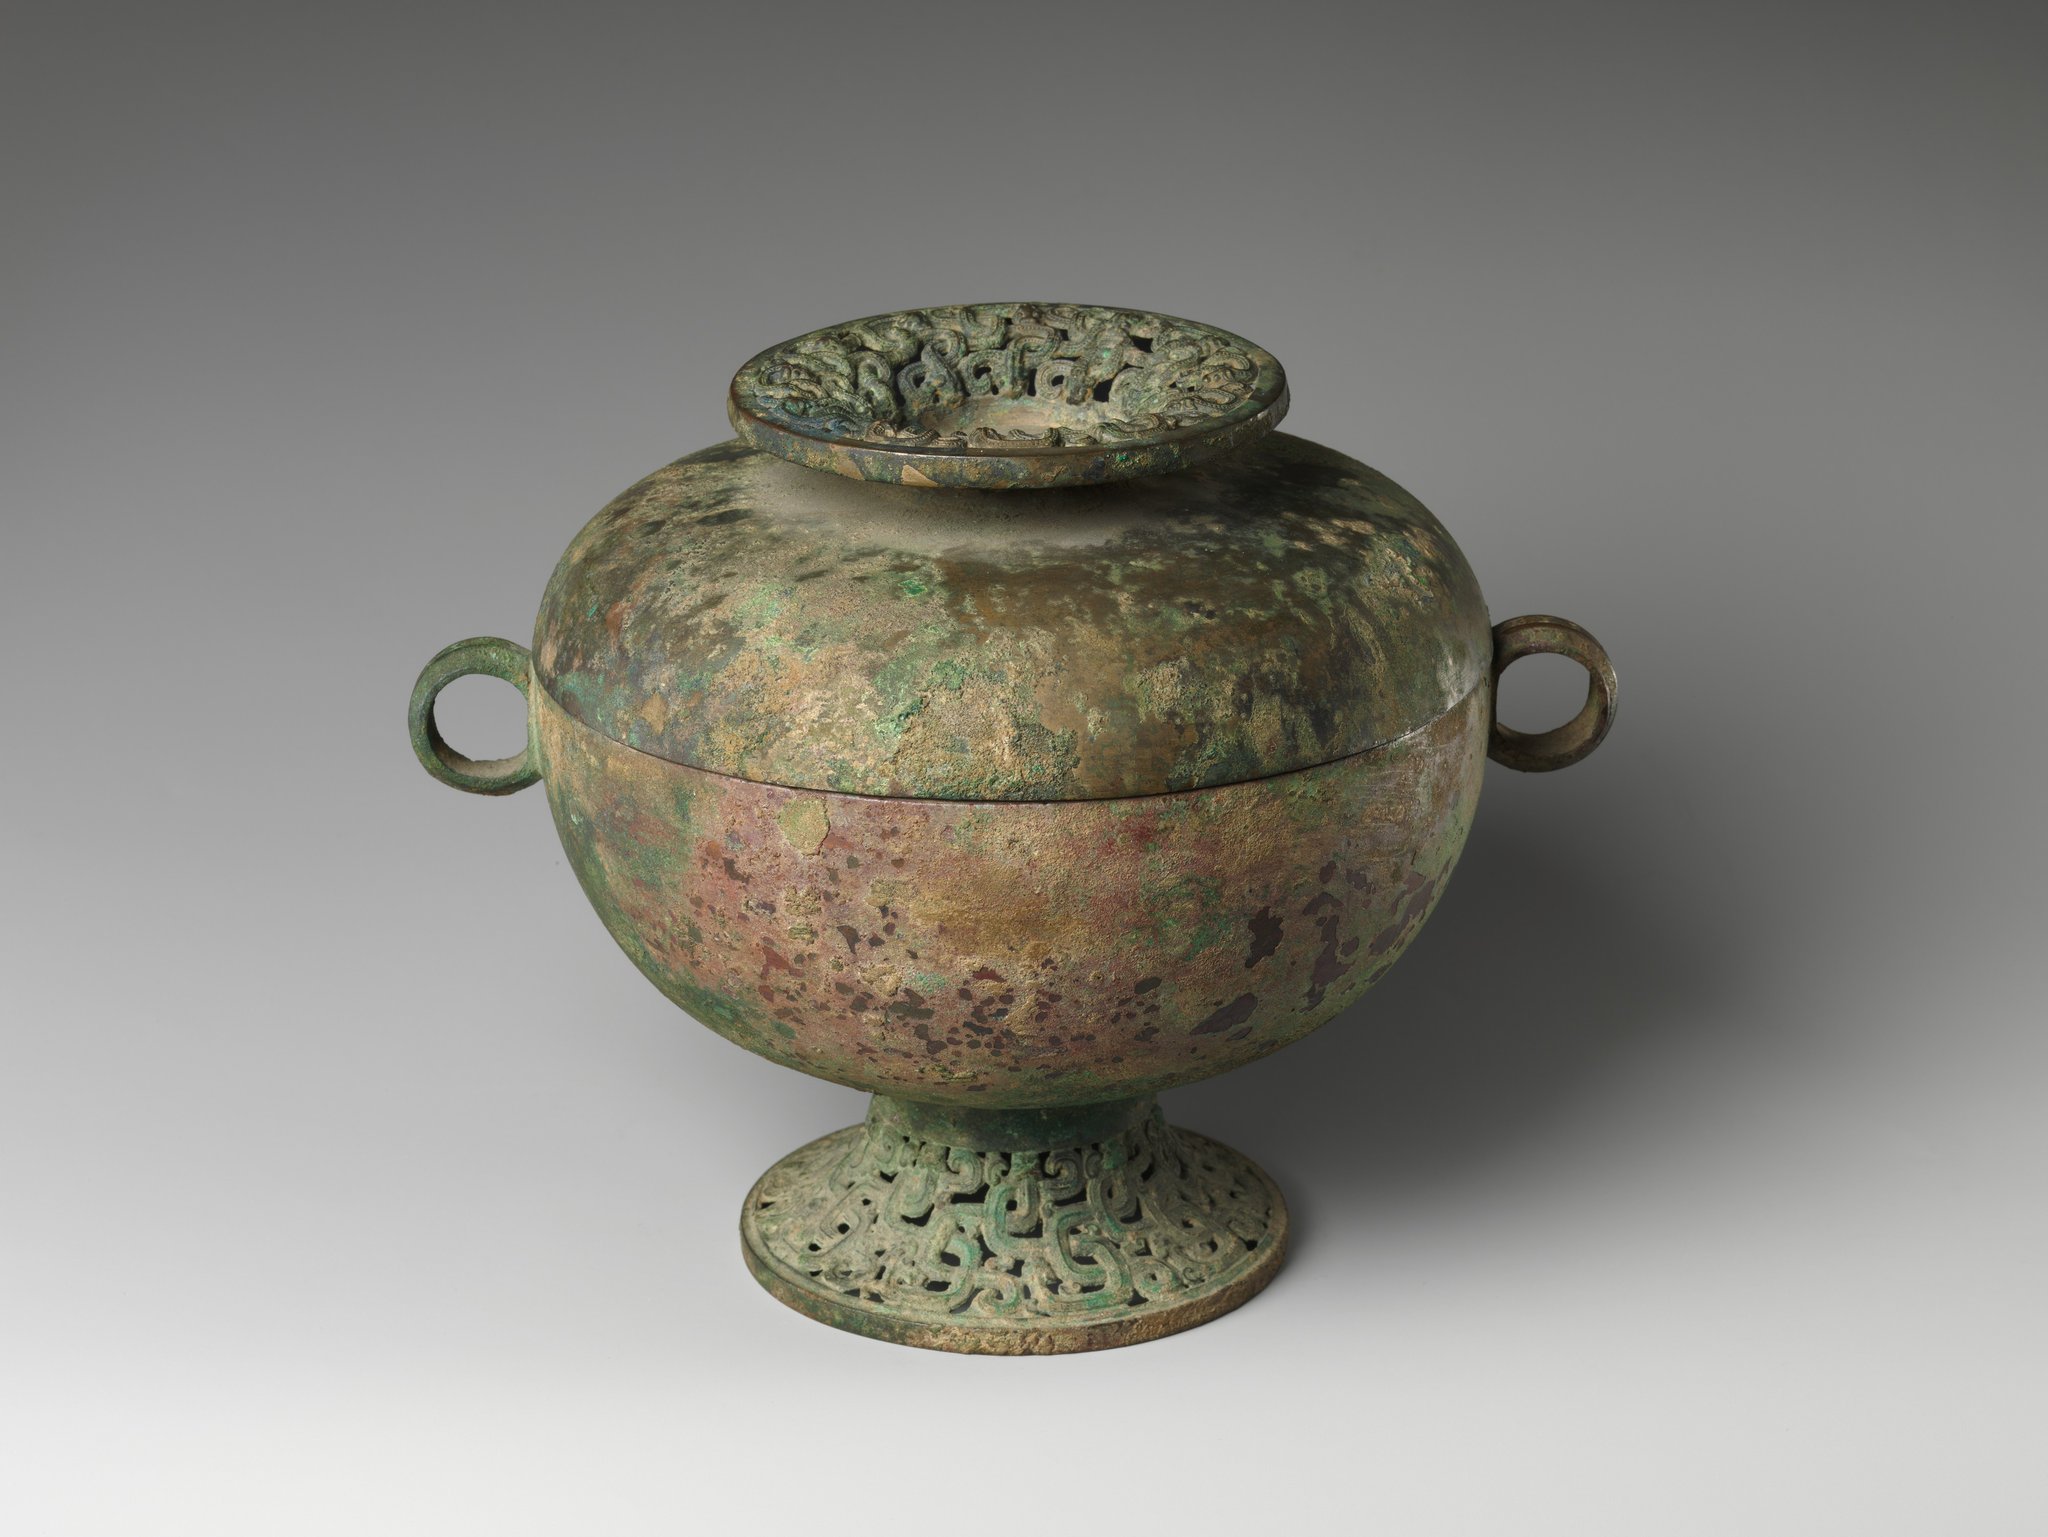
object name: grain serving vessel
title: Ritual grain serving vessel (Dou)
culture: chinese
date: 500-401 BCE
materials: bronze